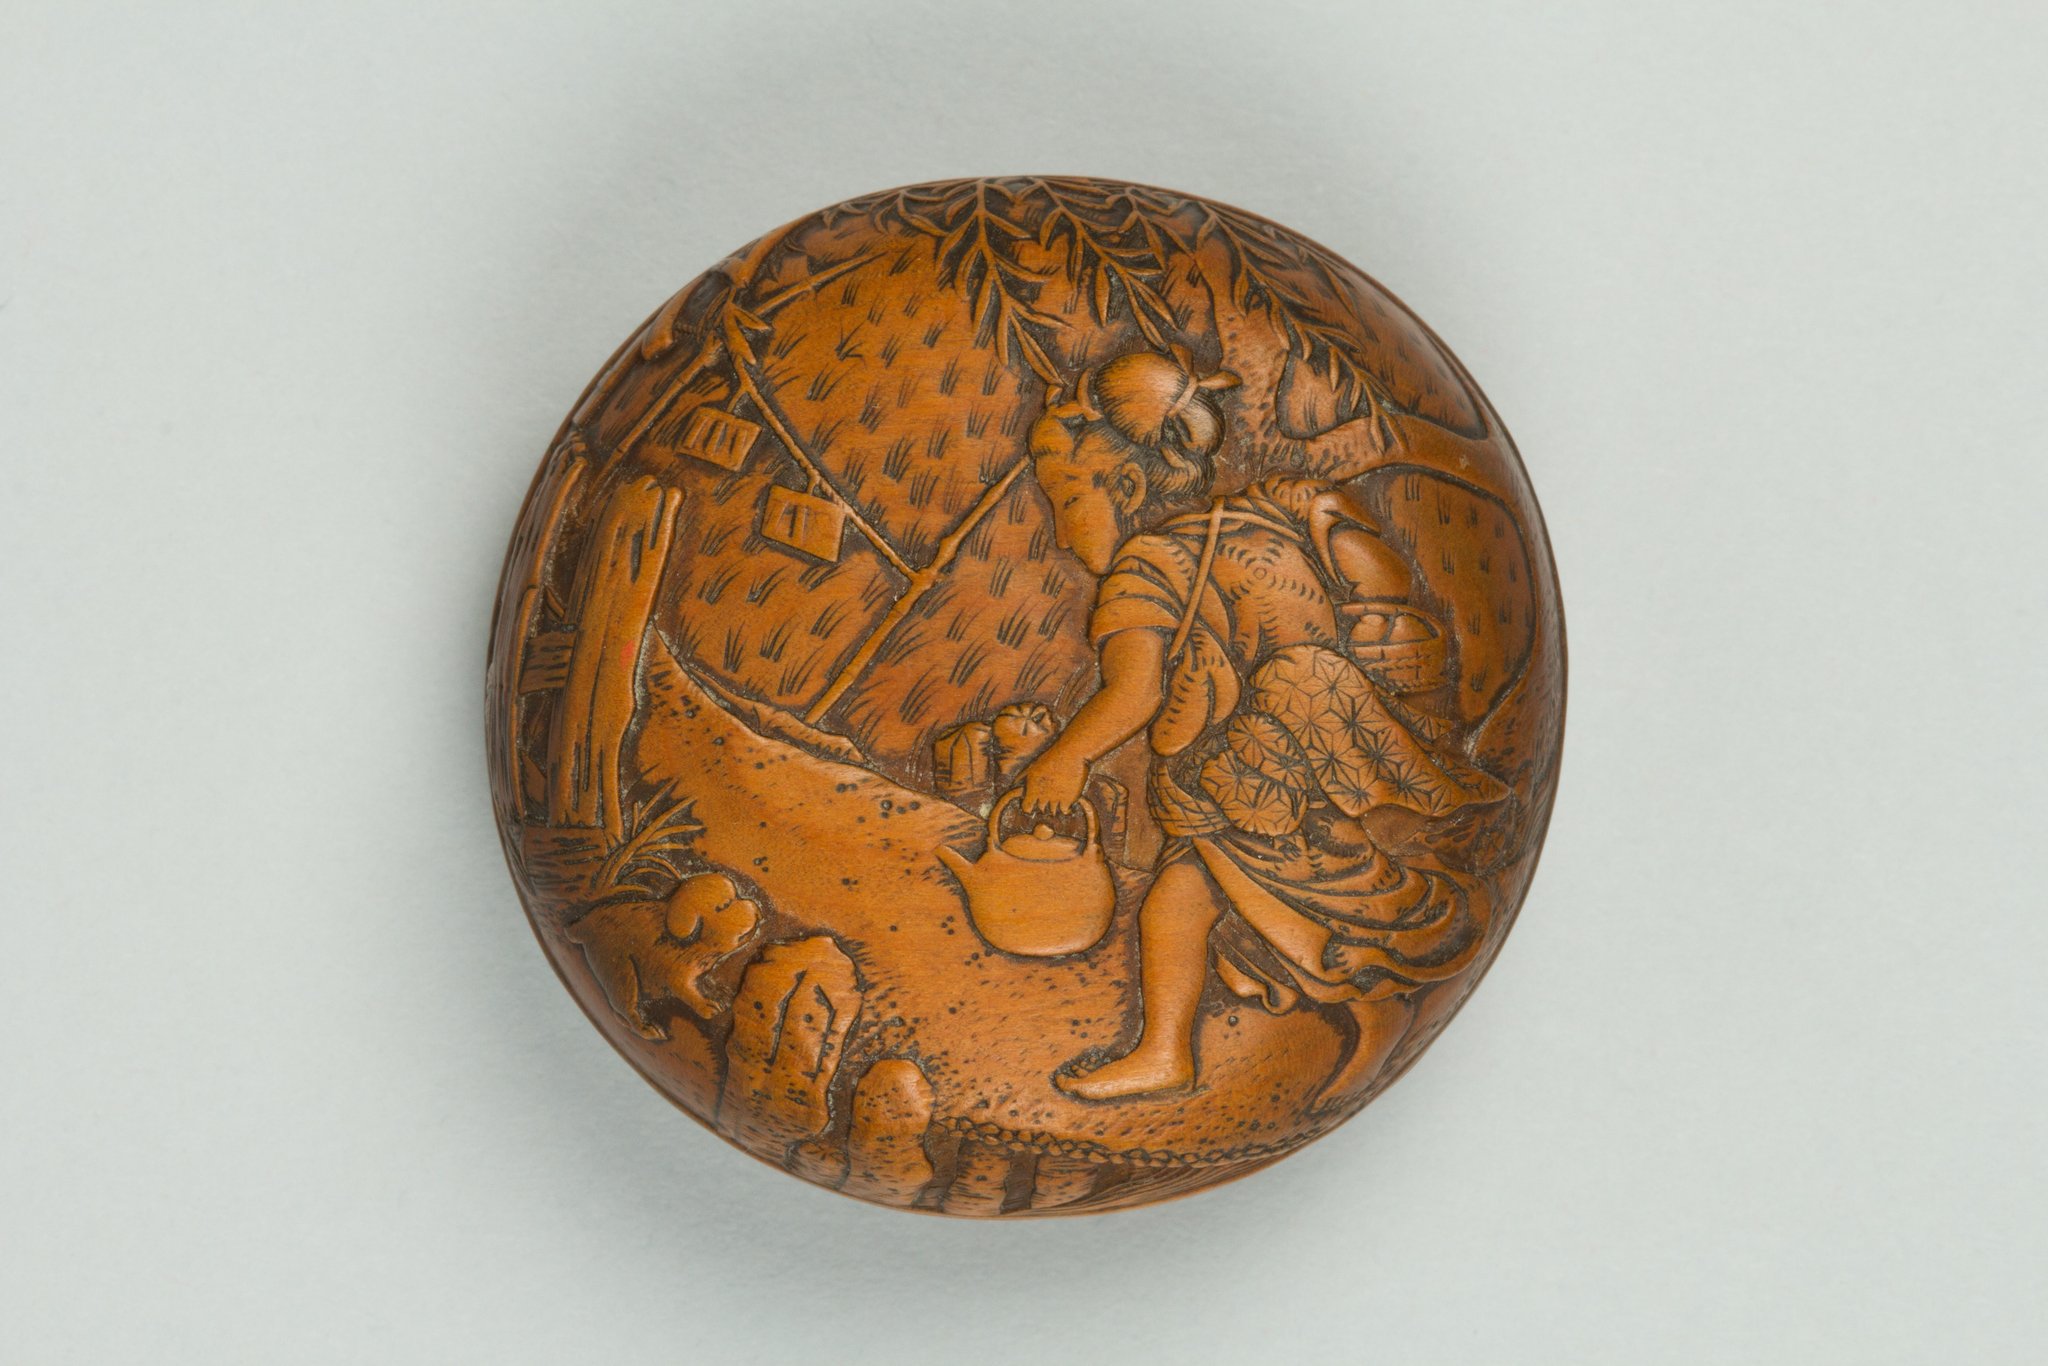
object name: netsuke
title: Netsuke of Peasant Girl Bringing Lunch; on reverse, a Scarecrow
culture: japanese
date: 1801-1900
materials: wood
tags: girls